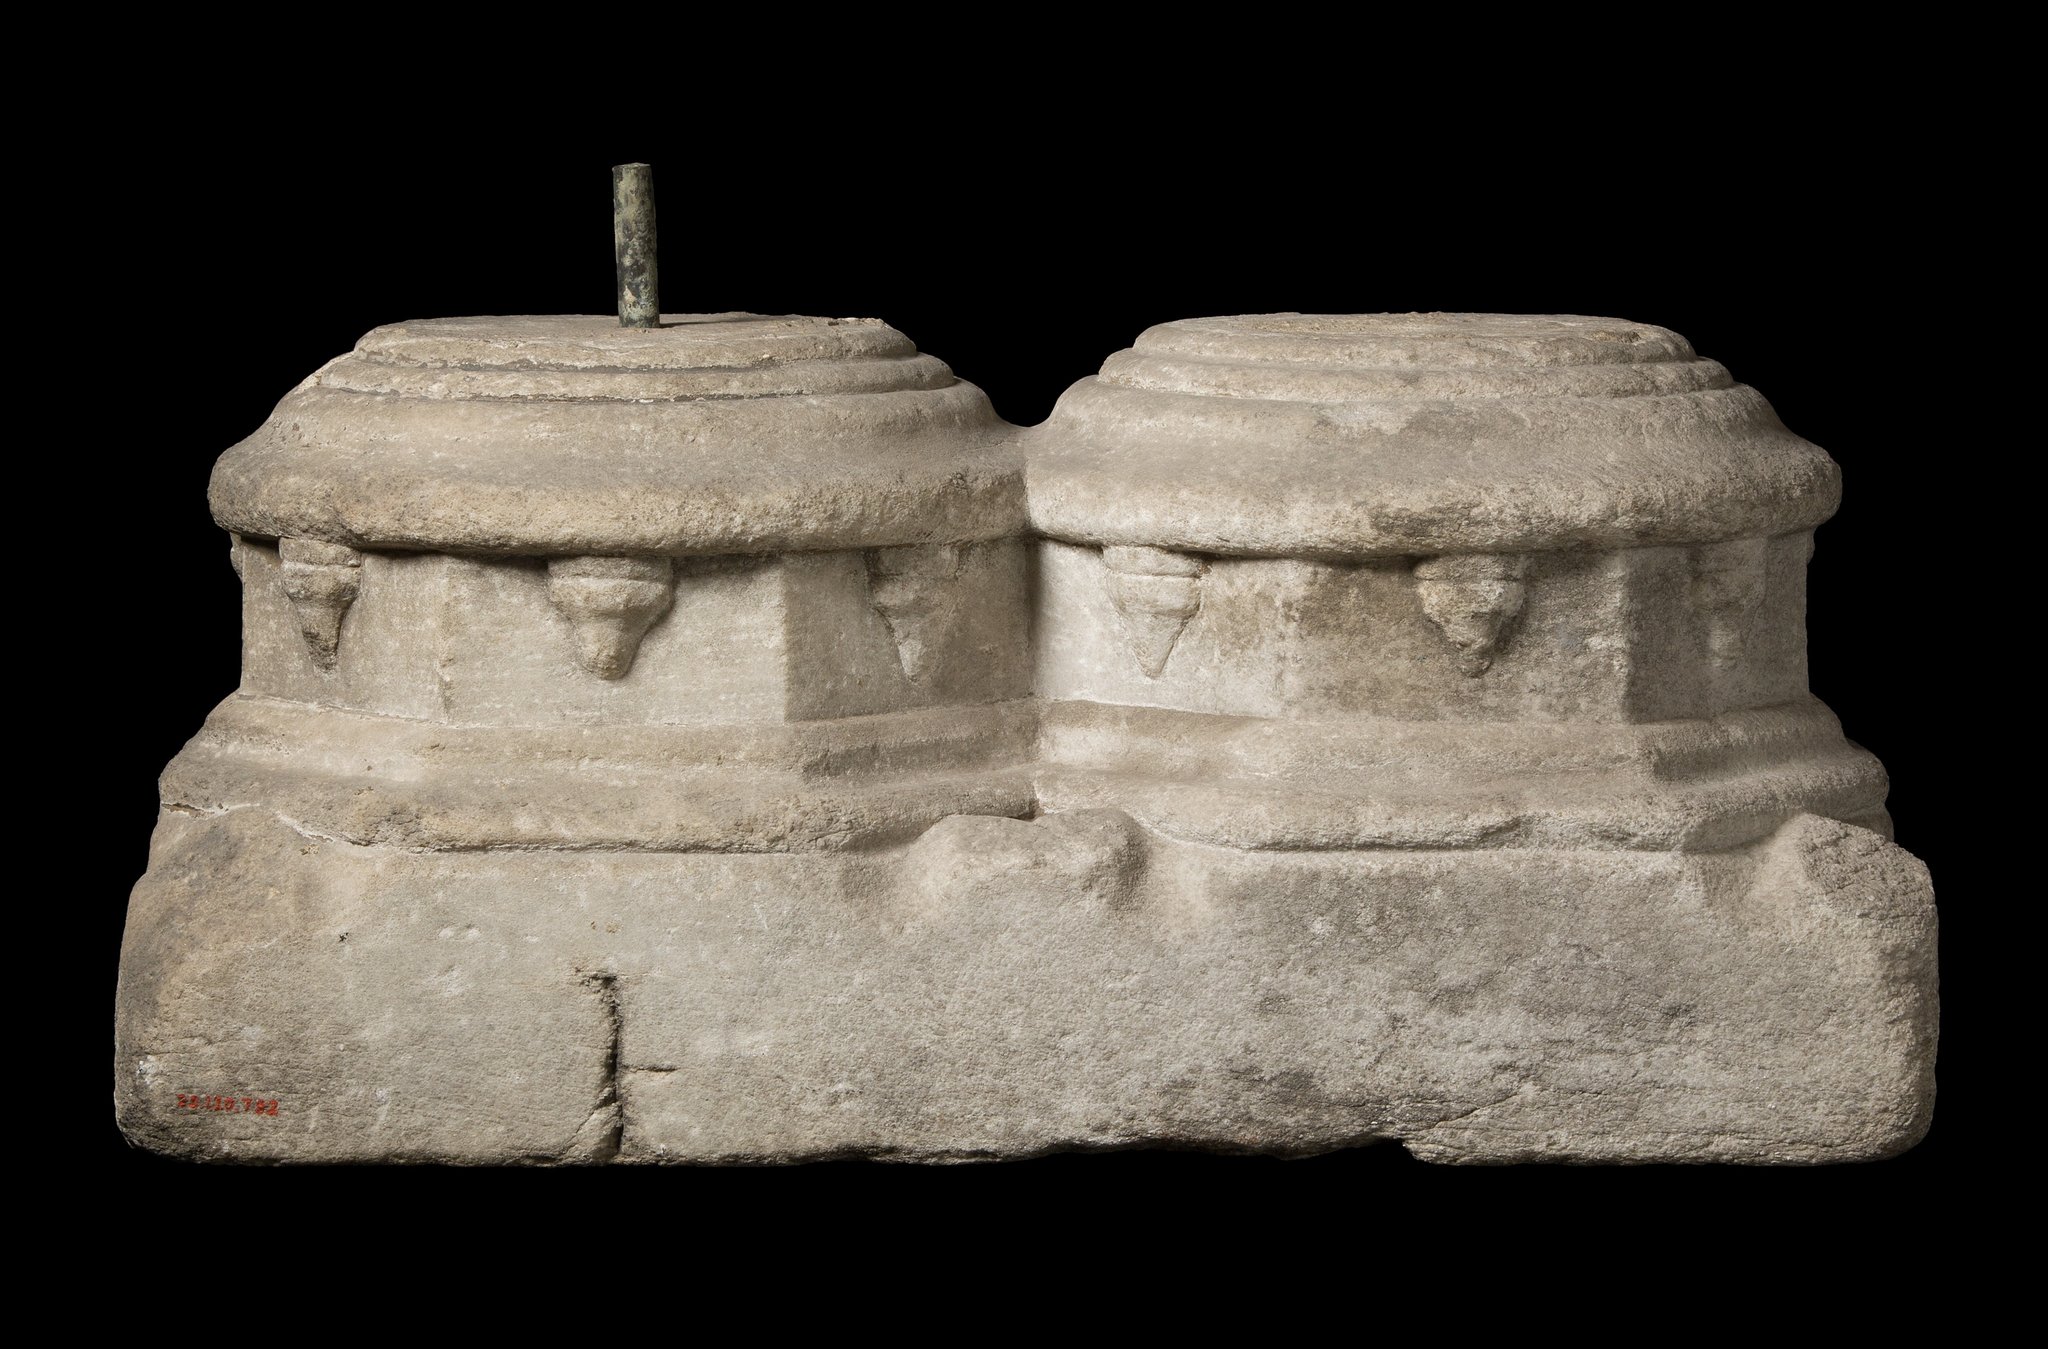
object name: base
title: Double Column Base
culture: french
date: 1267-1333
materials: marble